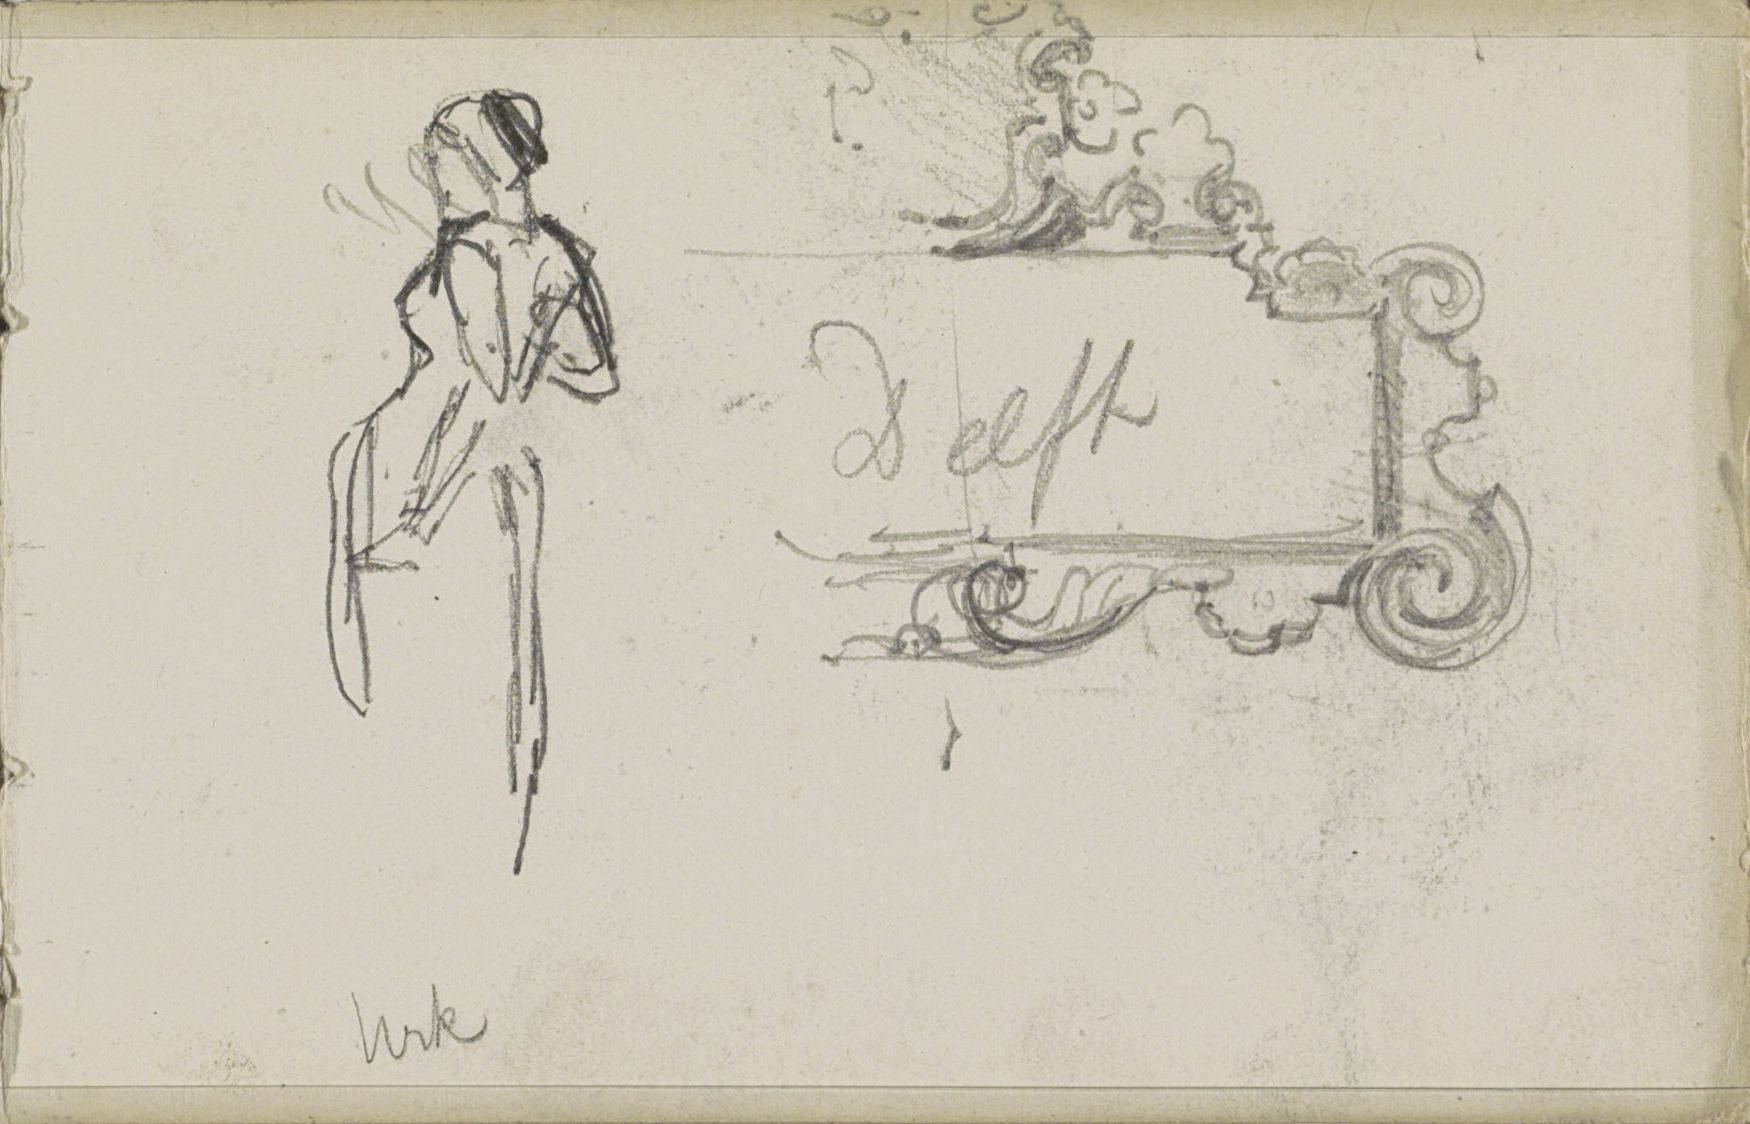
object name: sketchbook leaf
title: Urker vrouw en een gedecoreerd plaatsnaambord met de naam 'Delft'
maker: george clausen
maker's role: draughtsman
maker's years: 1852-1912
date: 1875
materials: paper, pencil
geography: delft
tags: adult woman, folk costume, regional costume, ribbon, scroll, banderole ~ ornament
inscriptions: annotation: ‘Urk/ Delft’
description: Blad 3 recto uit een schetsboek met 38 bladen.